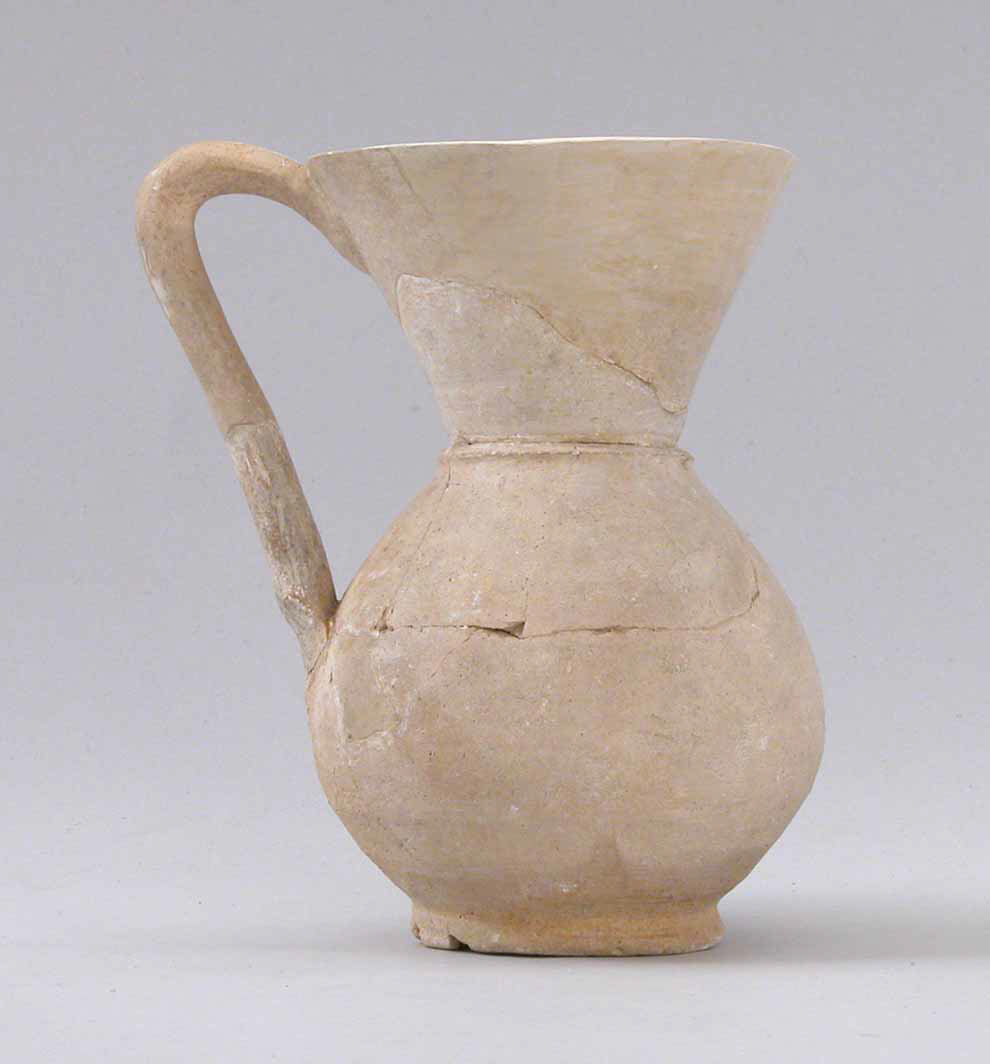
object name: ewer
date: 801-1000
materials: earthenware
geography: iran